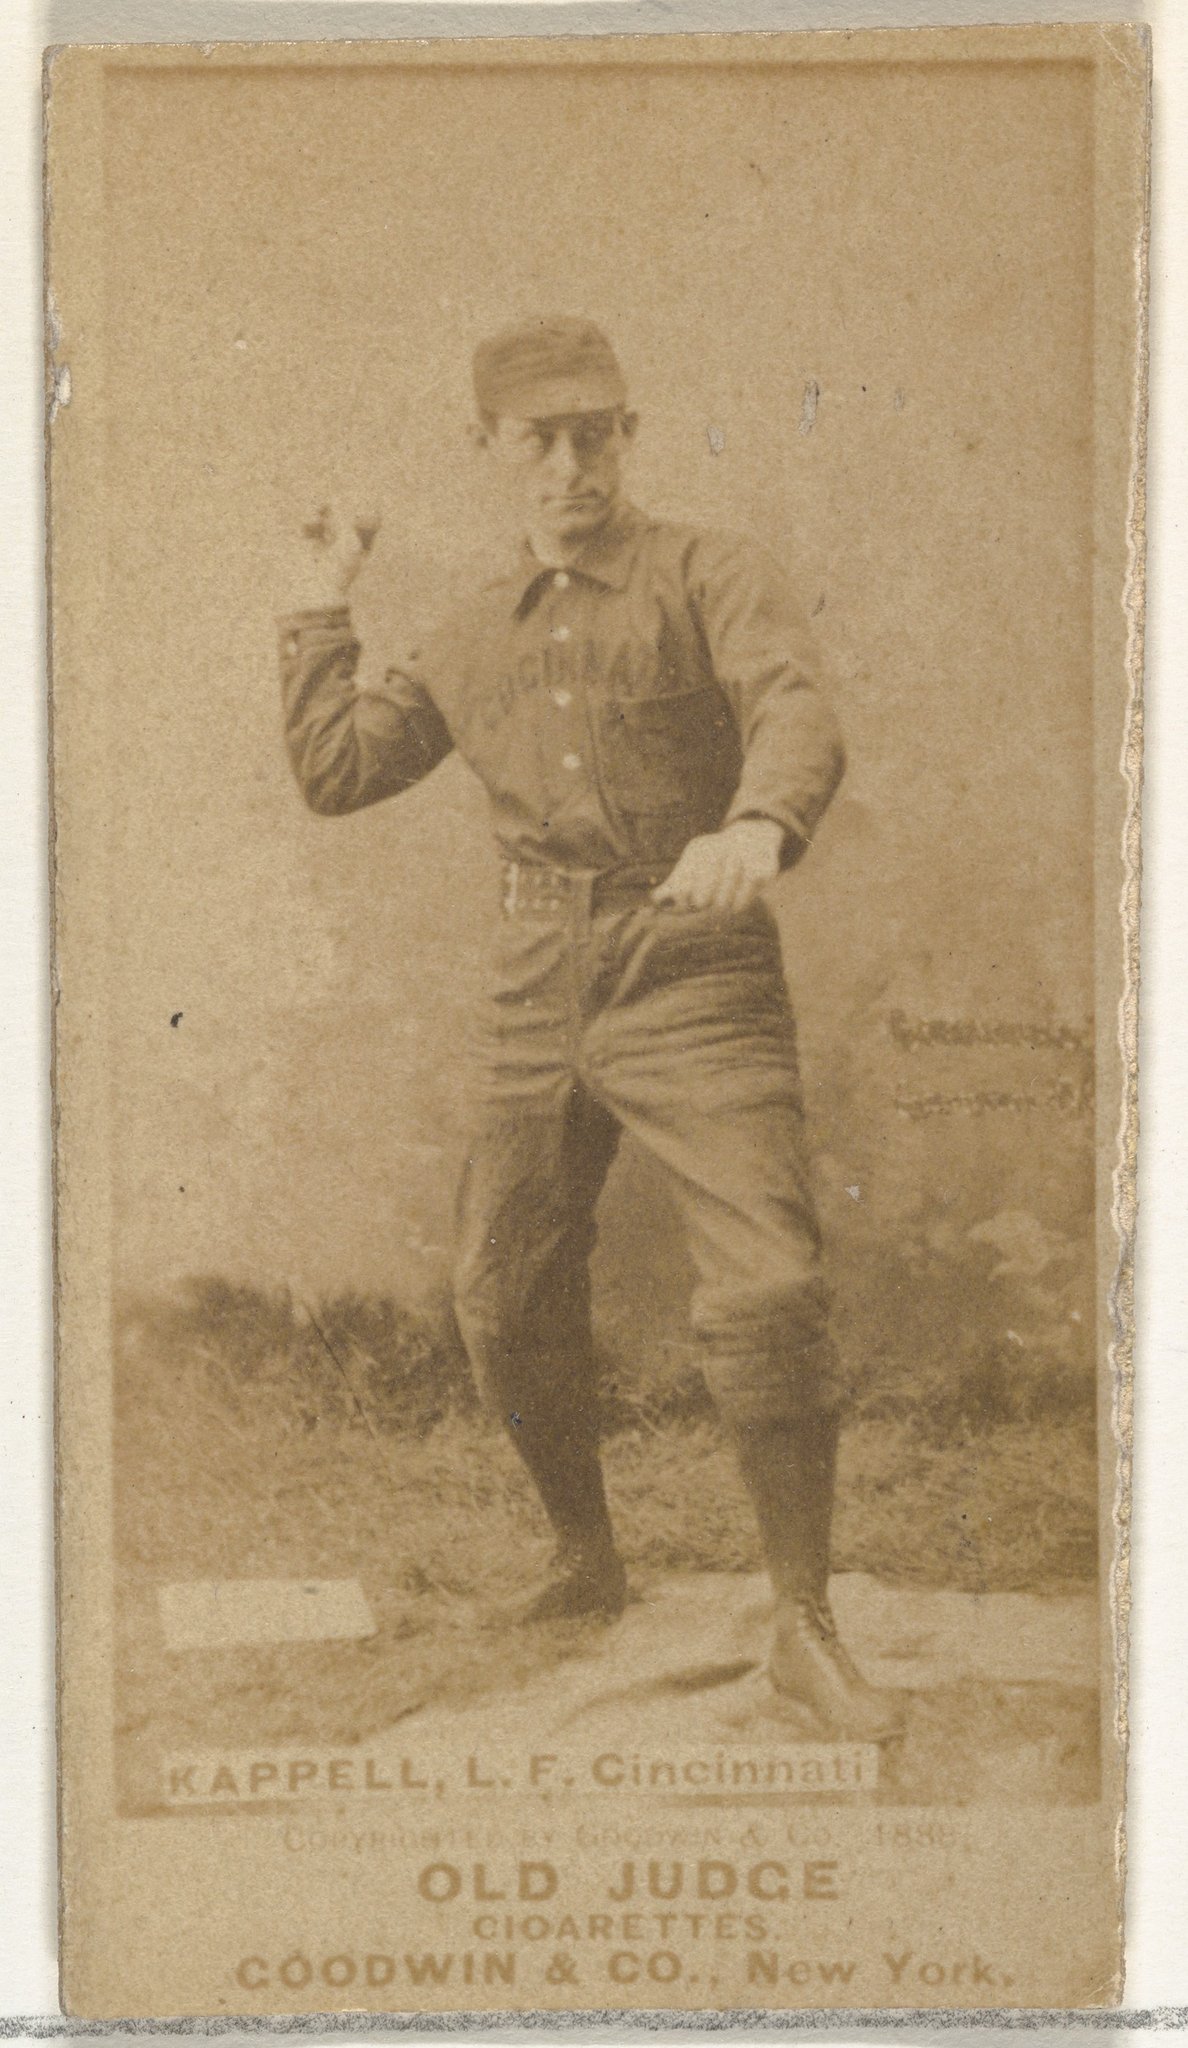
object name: baseball card, photograph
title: Henry "Heinie" Kappel, Left Field, Cincinnati, from the Old Judge series (N172) for Old Judge Cigarettes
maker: goodwin & company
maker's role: publisher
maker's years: 1850-1950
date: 1888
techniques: albumen silver print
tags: men,portraits,baseball,athletes